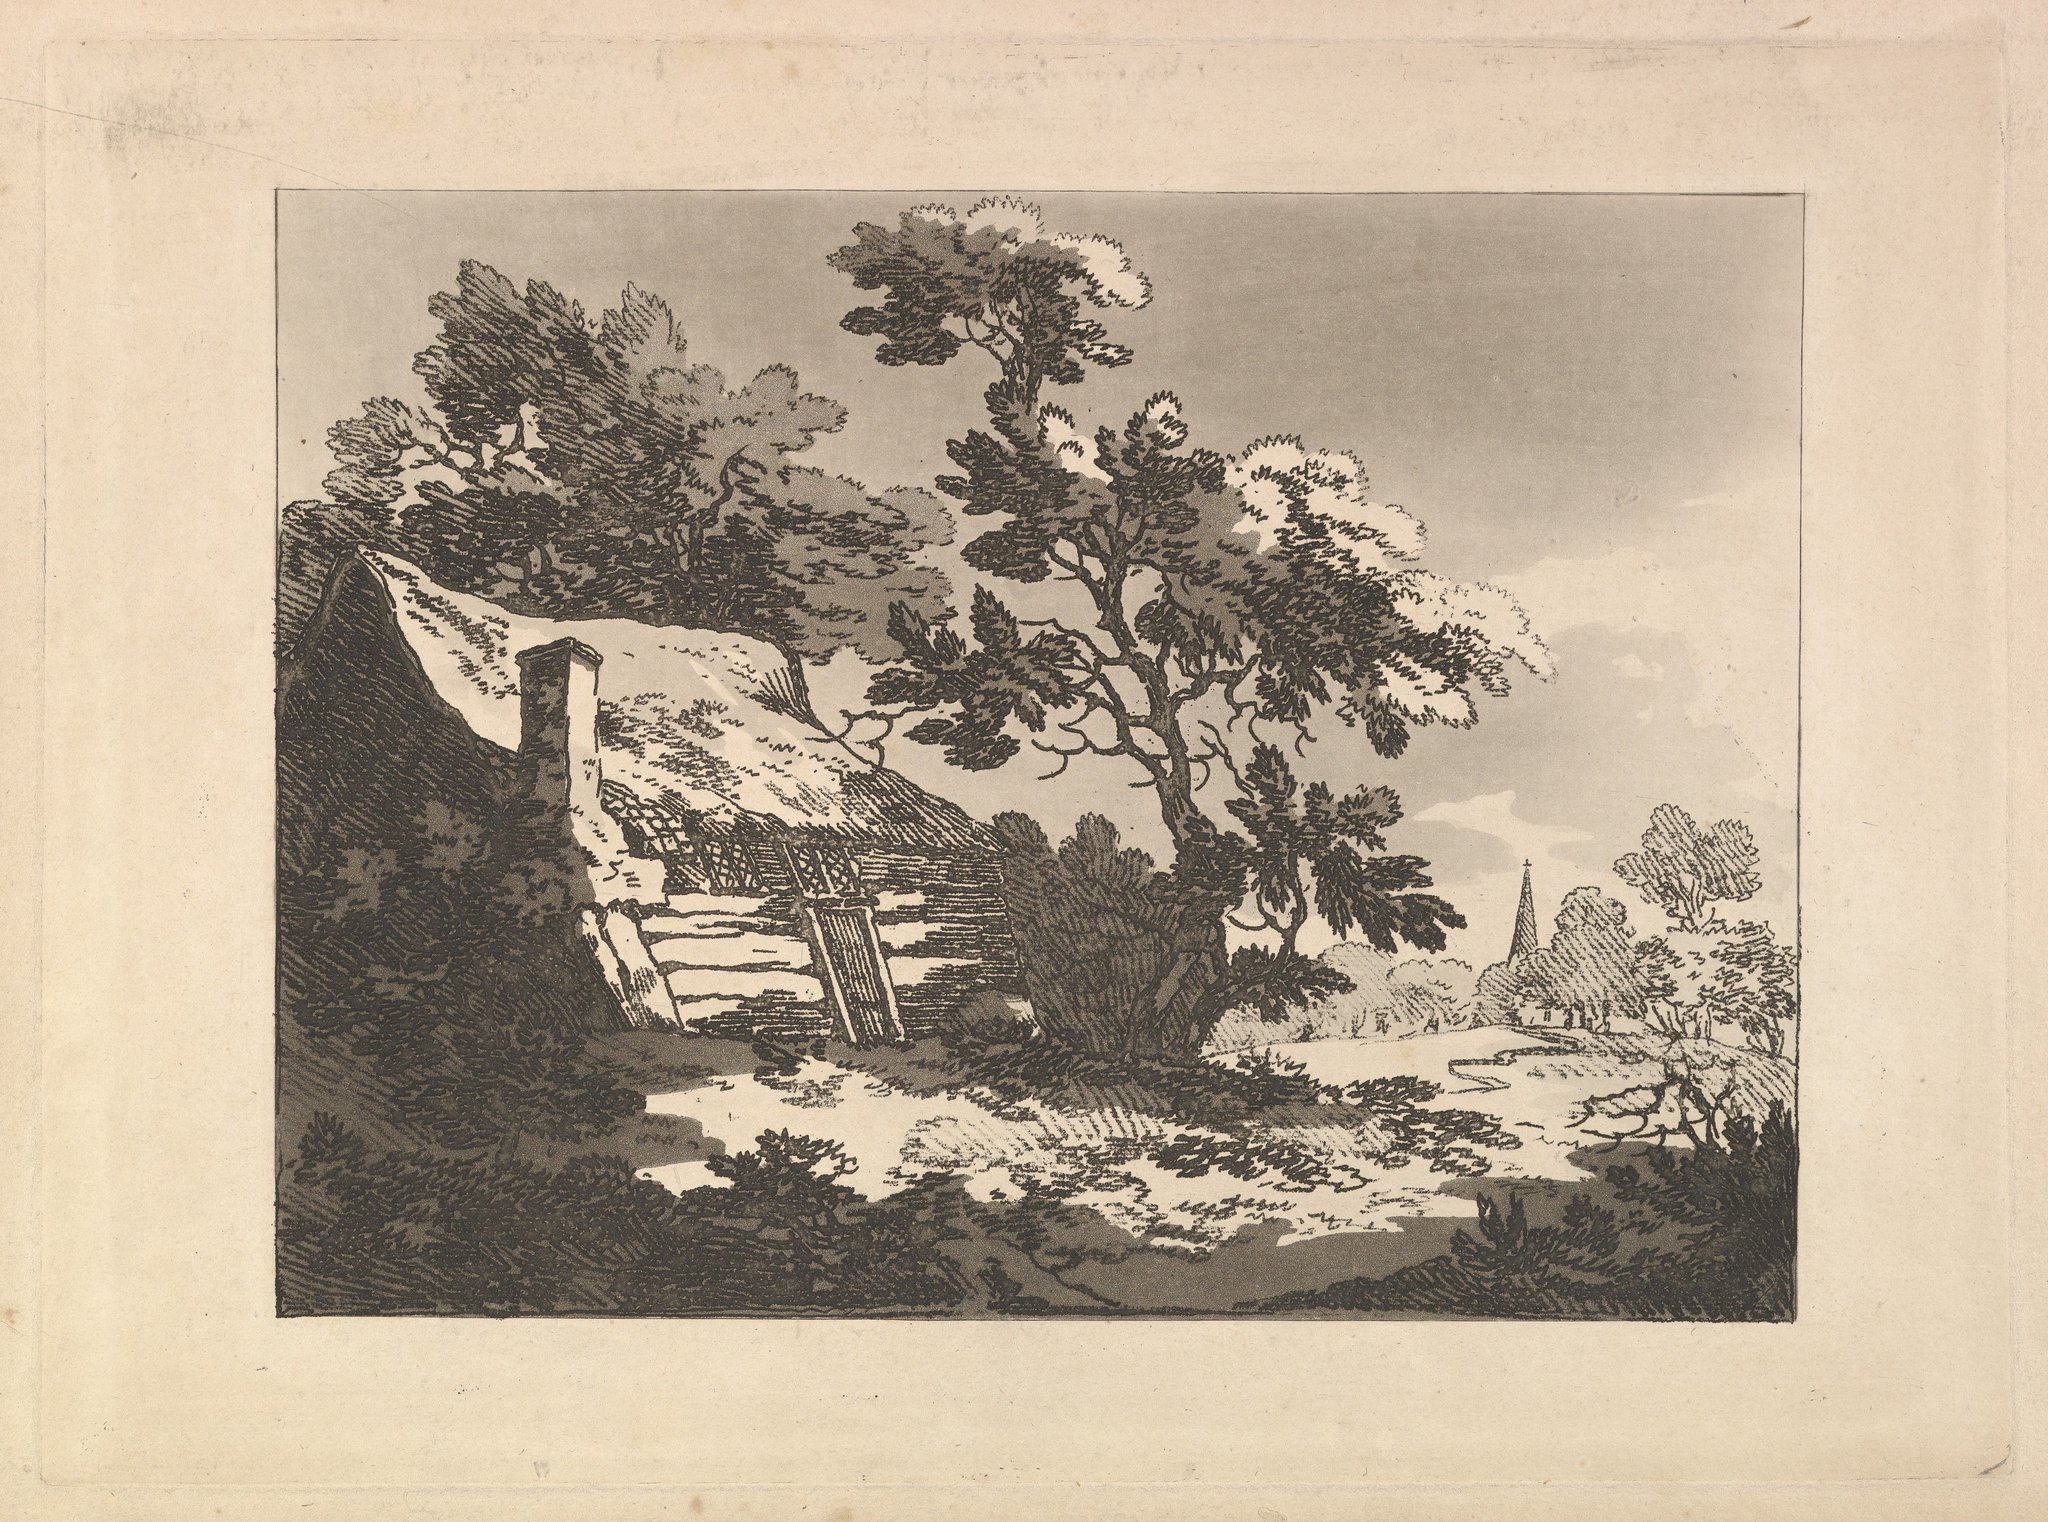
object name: print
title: Landscape with Cottage Among Trees at Left, and a Distant Church Spire at Right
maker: thomas rowlandson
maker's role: artist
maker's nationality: british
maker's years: 1757-1827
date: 1783-1784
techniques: aquatint, etching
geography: england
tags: houses,landscapes,trees